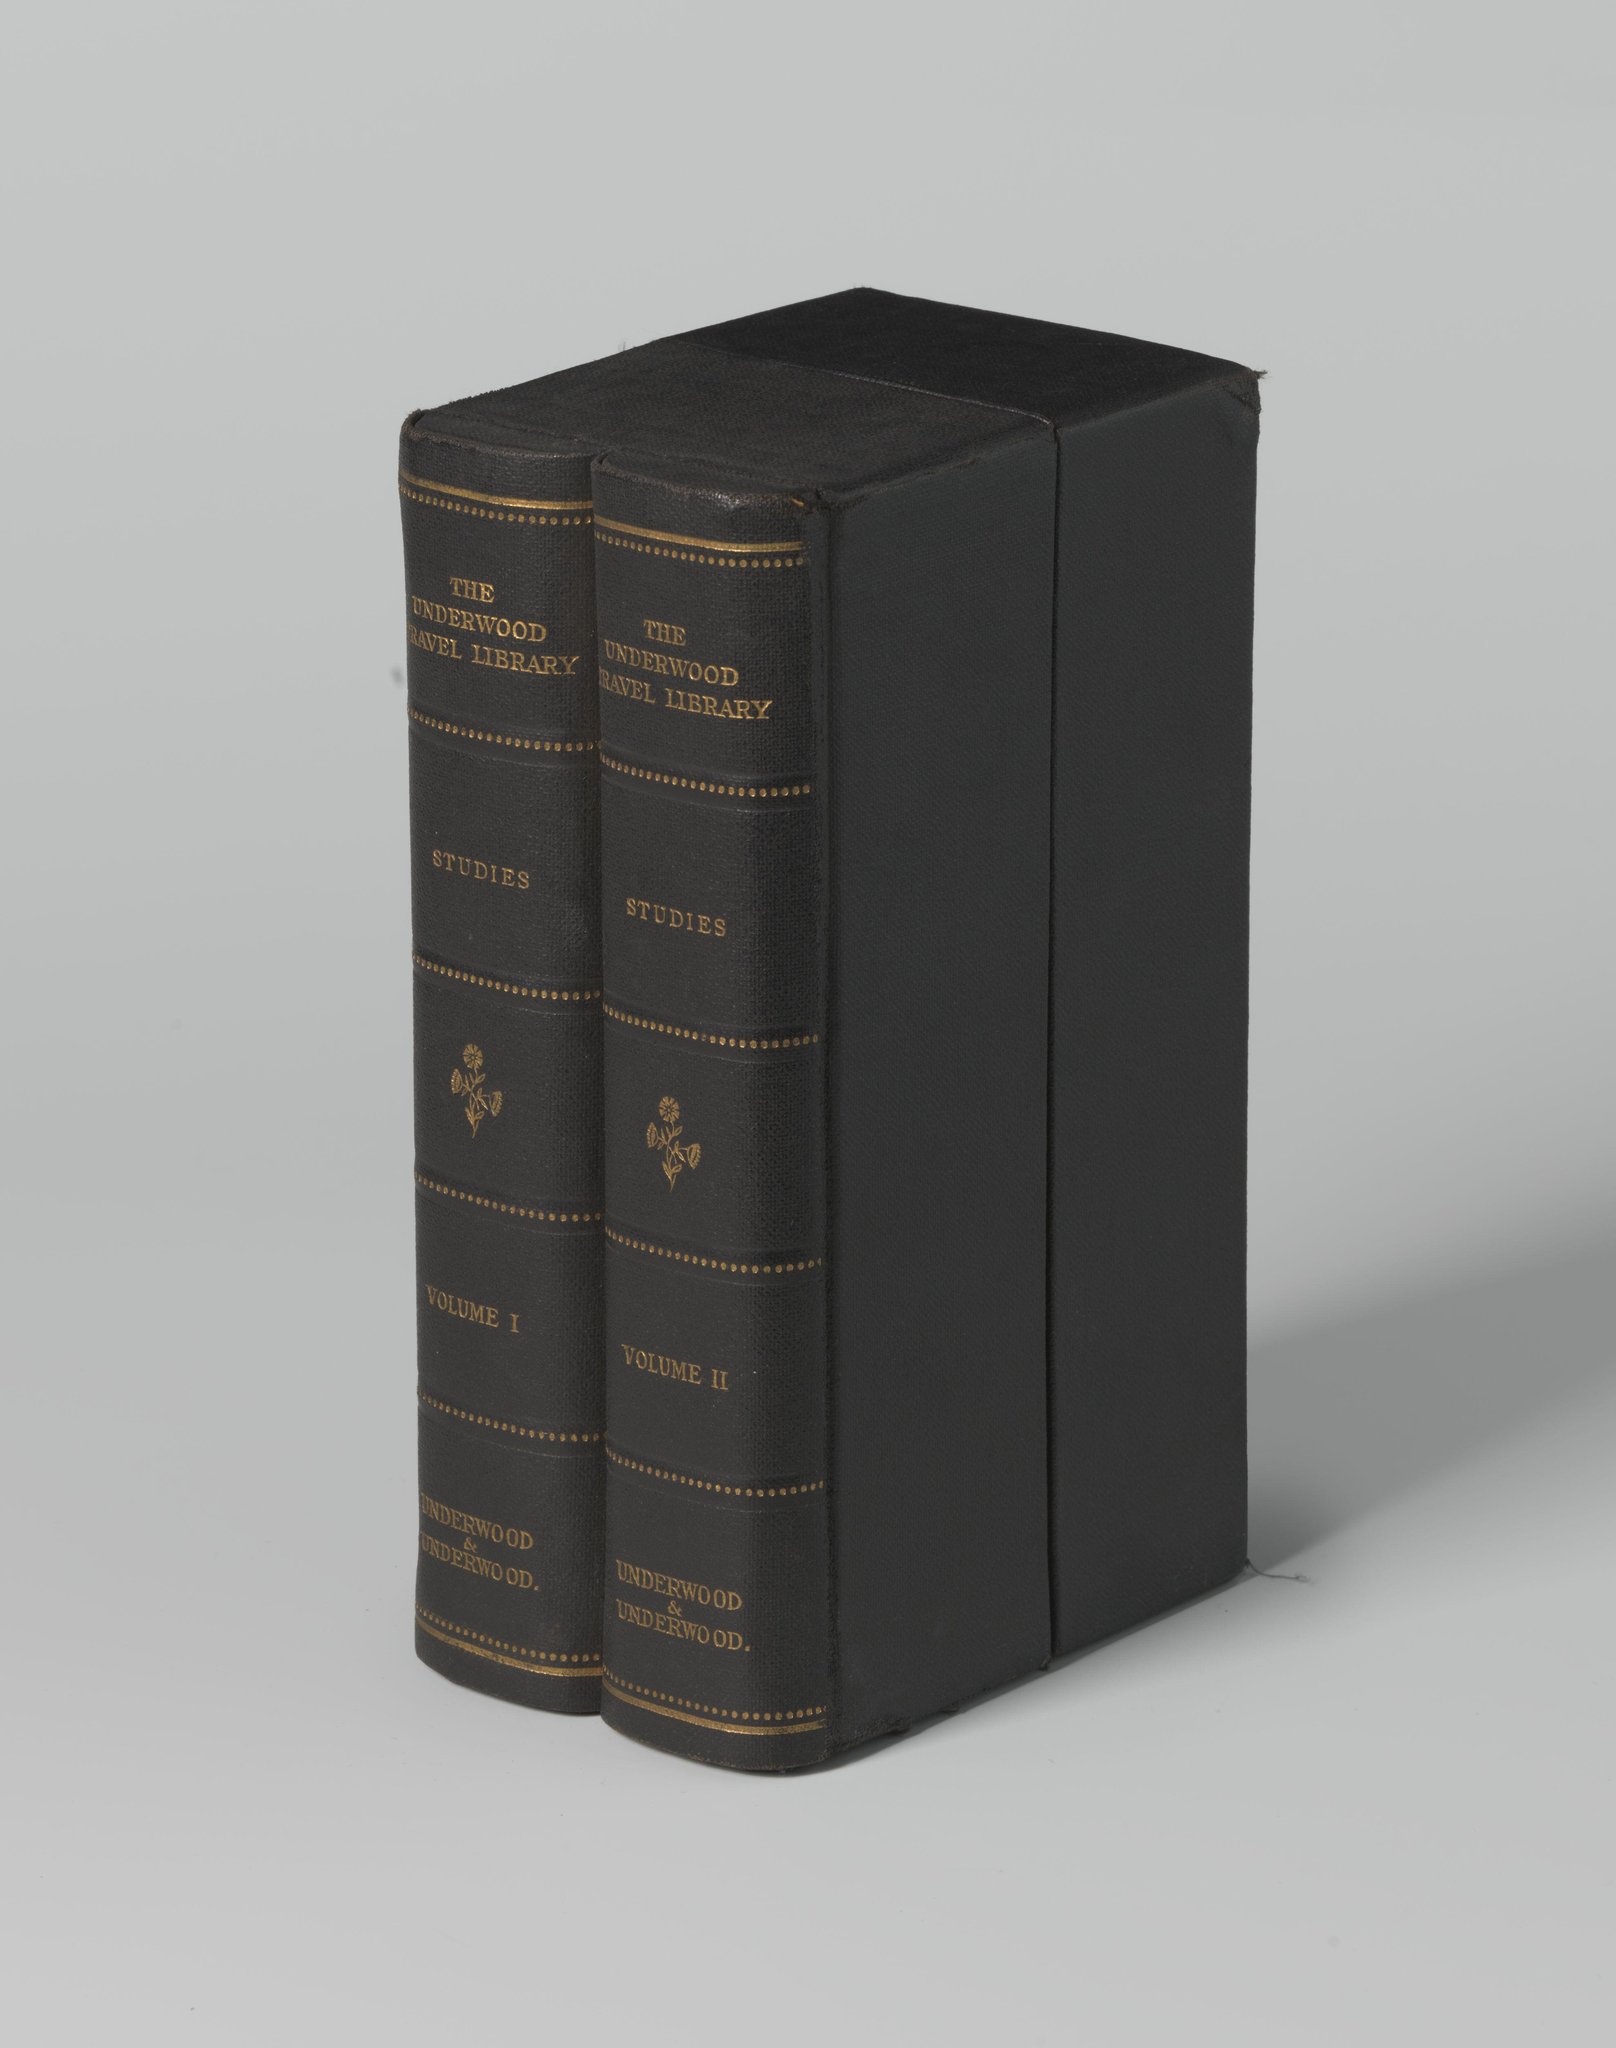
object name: box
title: The Underwood Travel Library, Studies, Volume I - II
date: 1890-1910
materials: cardboard, leather, paper, textile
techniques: moire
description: Doos in de vorm van twee boekbanden, voor het opbergen van stereofoto's (leeg).